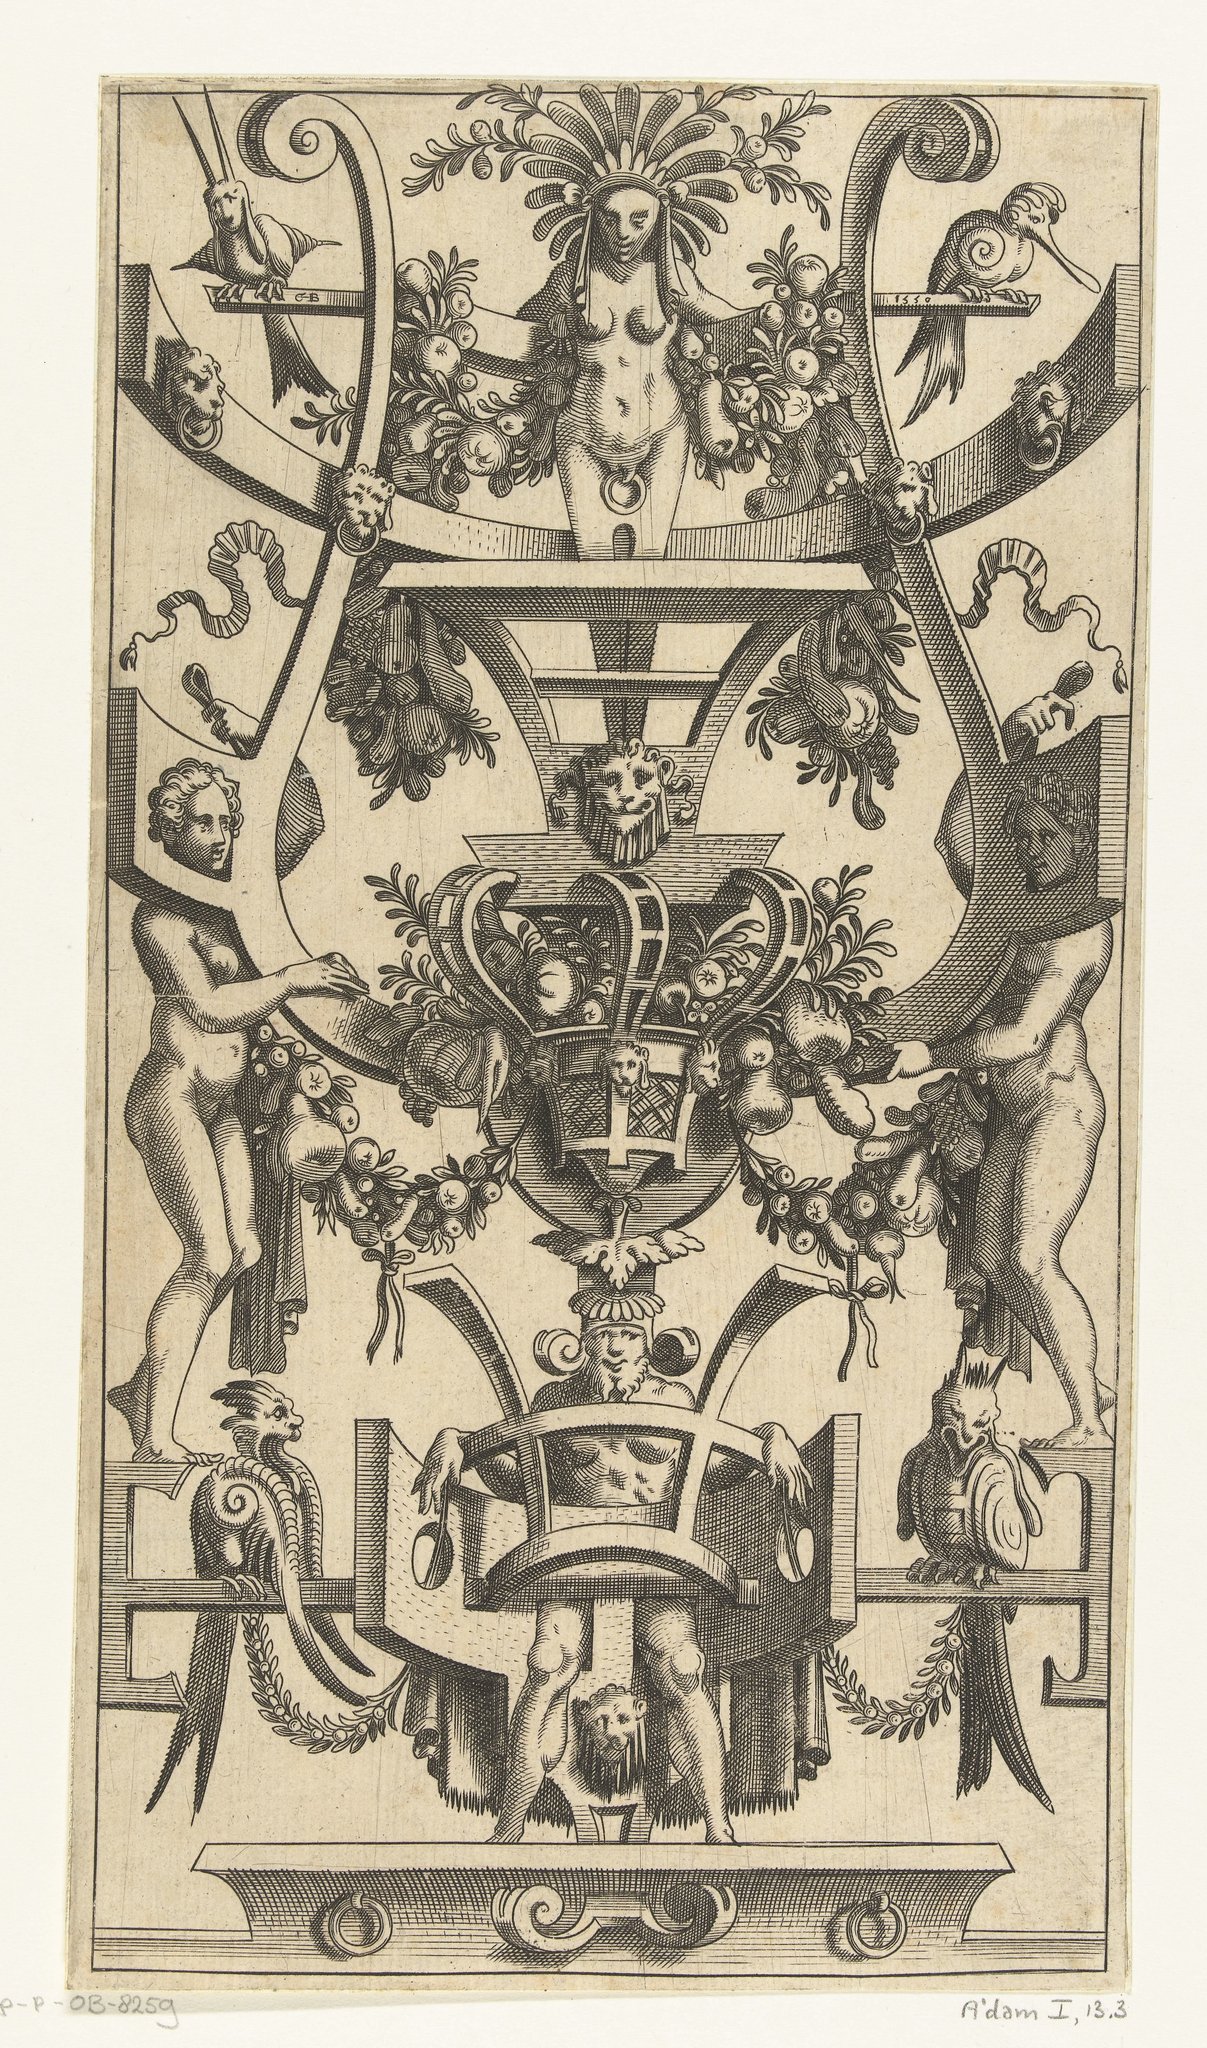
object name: print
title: Rolwerk met een vruchtenkorf in het midden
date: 1550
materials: paper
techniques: engraving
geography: netherlands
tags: ornament ~ grotesque, fruits and vegetables ~ ornament, scrollwork, strapwork ~ ornament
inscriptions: date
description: Boven de vruchtenkorf verheft zich een vrouwelijke herme, eronder staat een man, wiens benen door het rolwerk heen steken. Blad uit serie van 6 bladen met groteske vlakdecoraties met rolwerk, kandelabers, saters, vruchtenguirlandes, vogels en fantasiewezens.